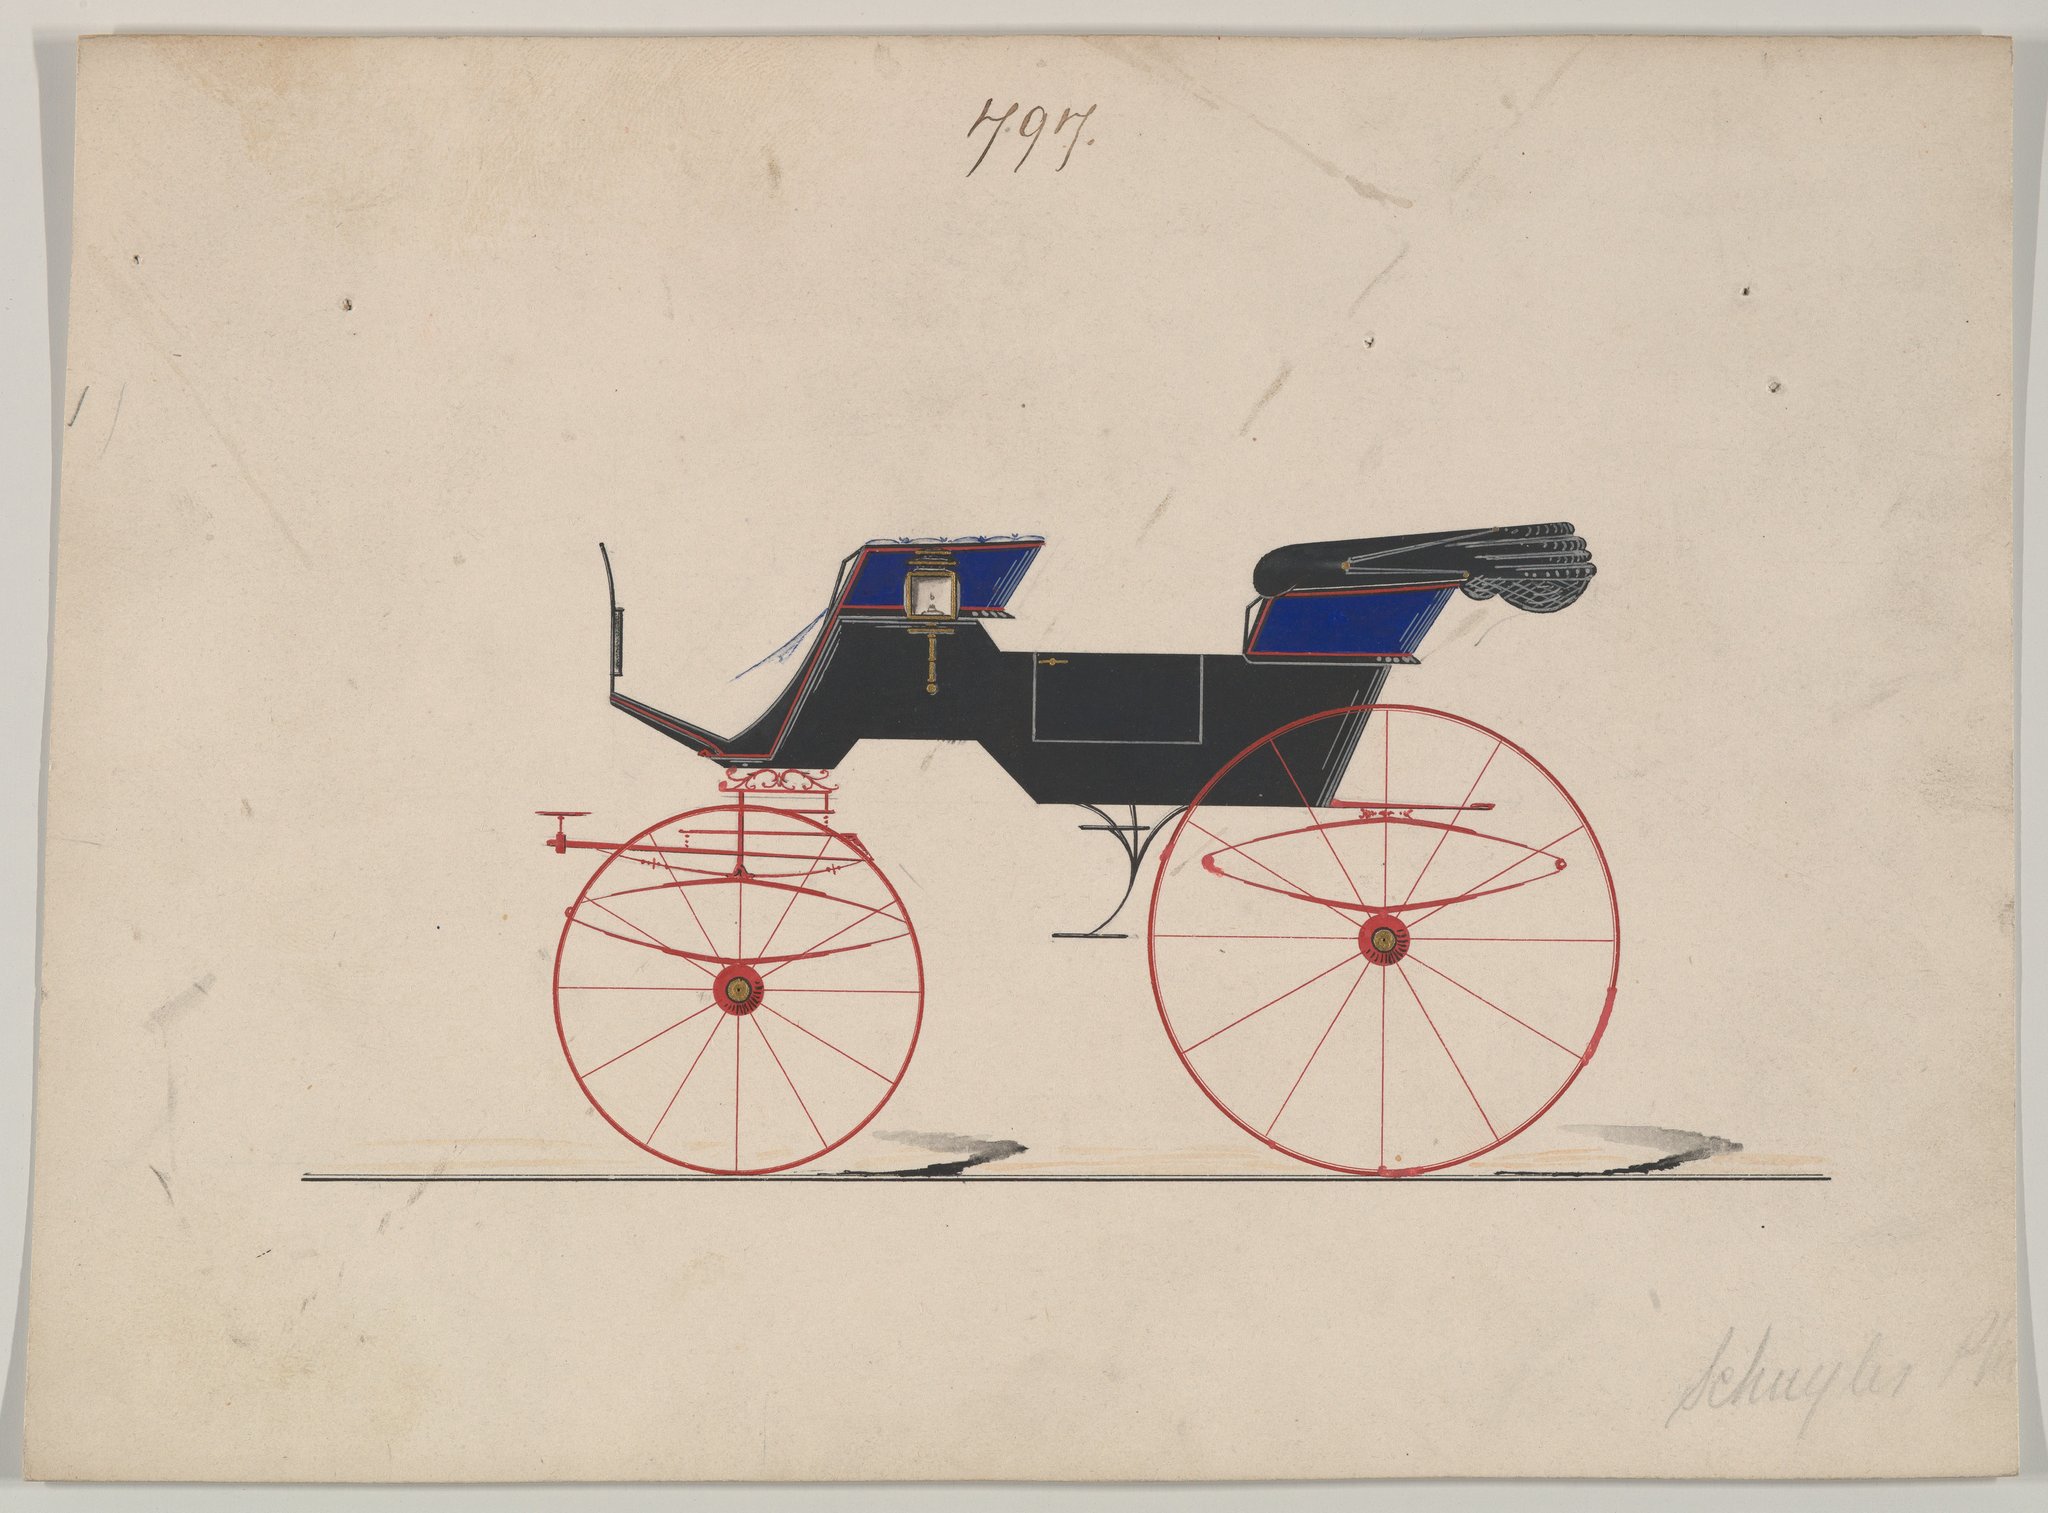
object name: drawing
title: Design for Phaeton, no. 797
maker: brewster & co.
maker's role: manufacturer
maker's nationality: american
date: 1850-1874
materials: gouache, graphite, ink, watercolor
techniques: pen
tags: carriages